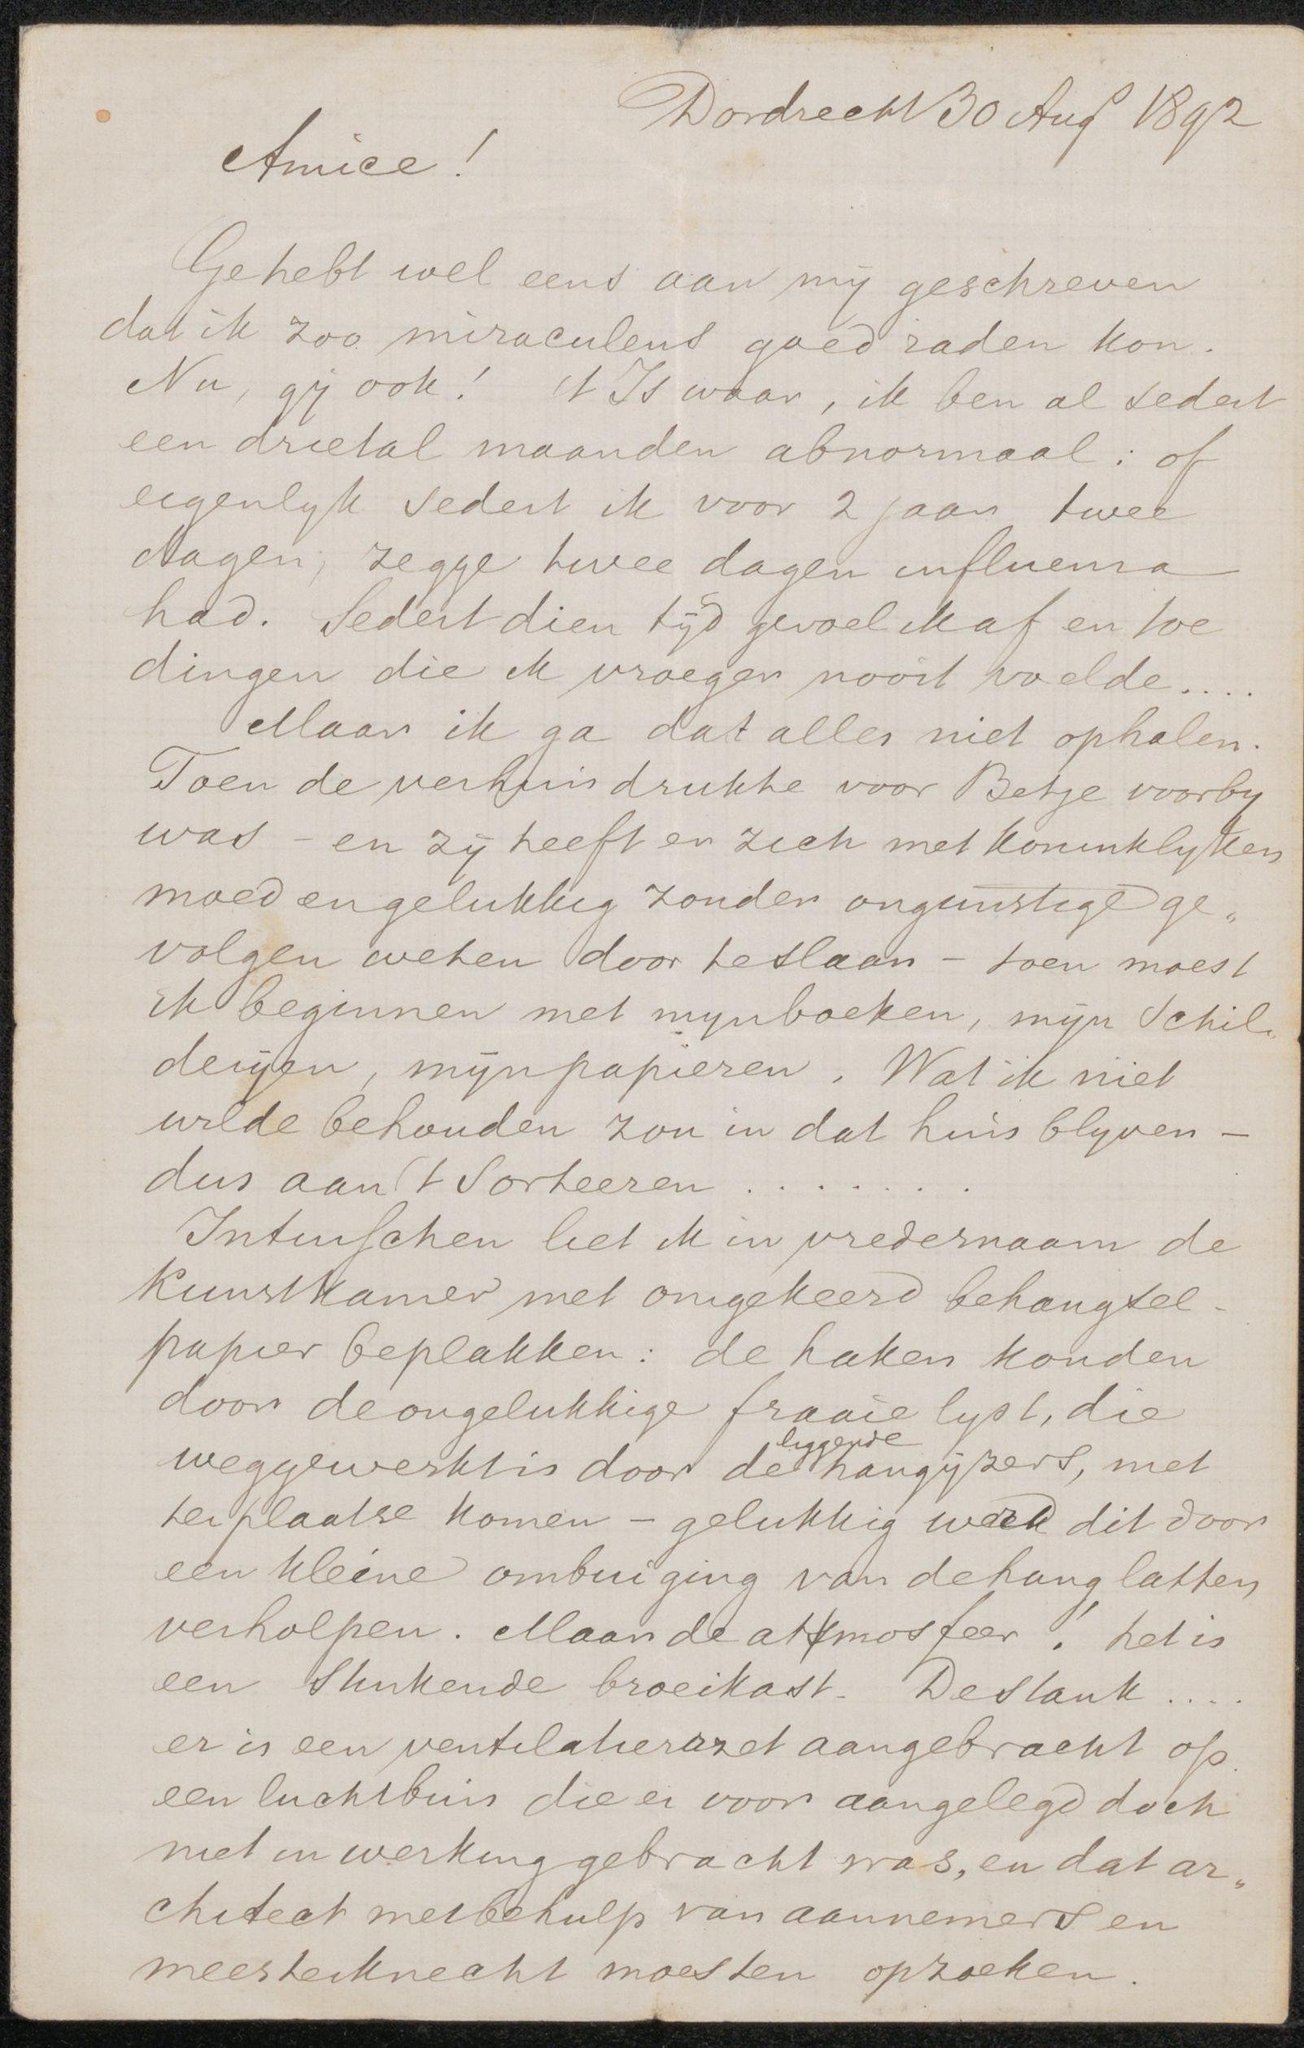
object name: letter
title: Brief aan Jan Veth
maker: martinus cornelis lebret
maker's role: verzamelaar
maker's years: 1833-1894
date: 1892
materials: ink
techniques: pen, writing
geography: dordrecht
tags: dordrecht, designer, jan veth, jacob maris, the hague, jan toorop, floris verster, leiden, amsterdam, painter, print maker, draughtsman, rembrandt van rijn, chap van deventer, hermanus gijsbertus tersteeg, the graphic arts, painting (including book-illumination, miniature-painting), diseases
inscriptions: collector's mark: ‘RPK’